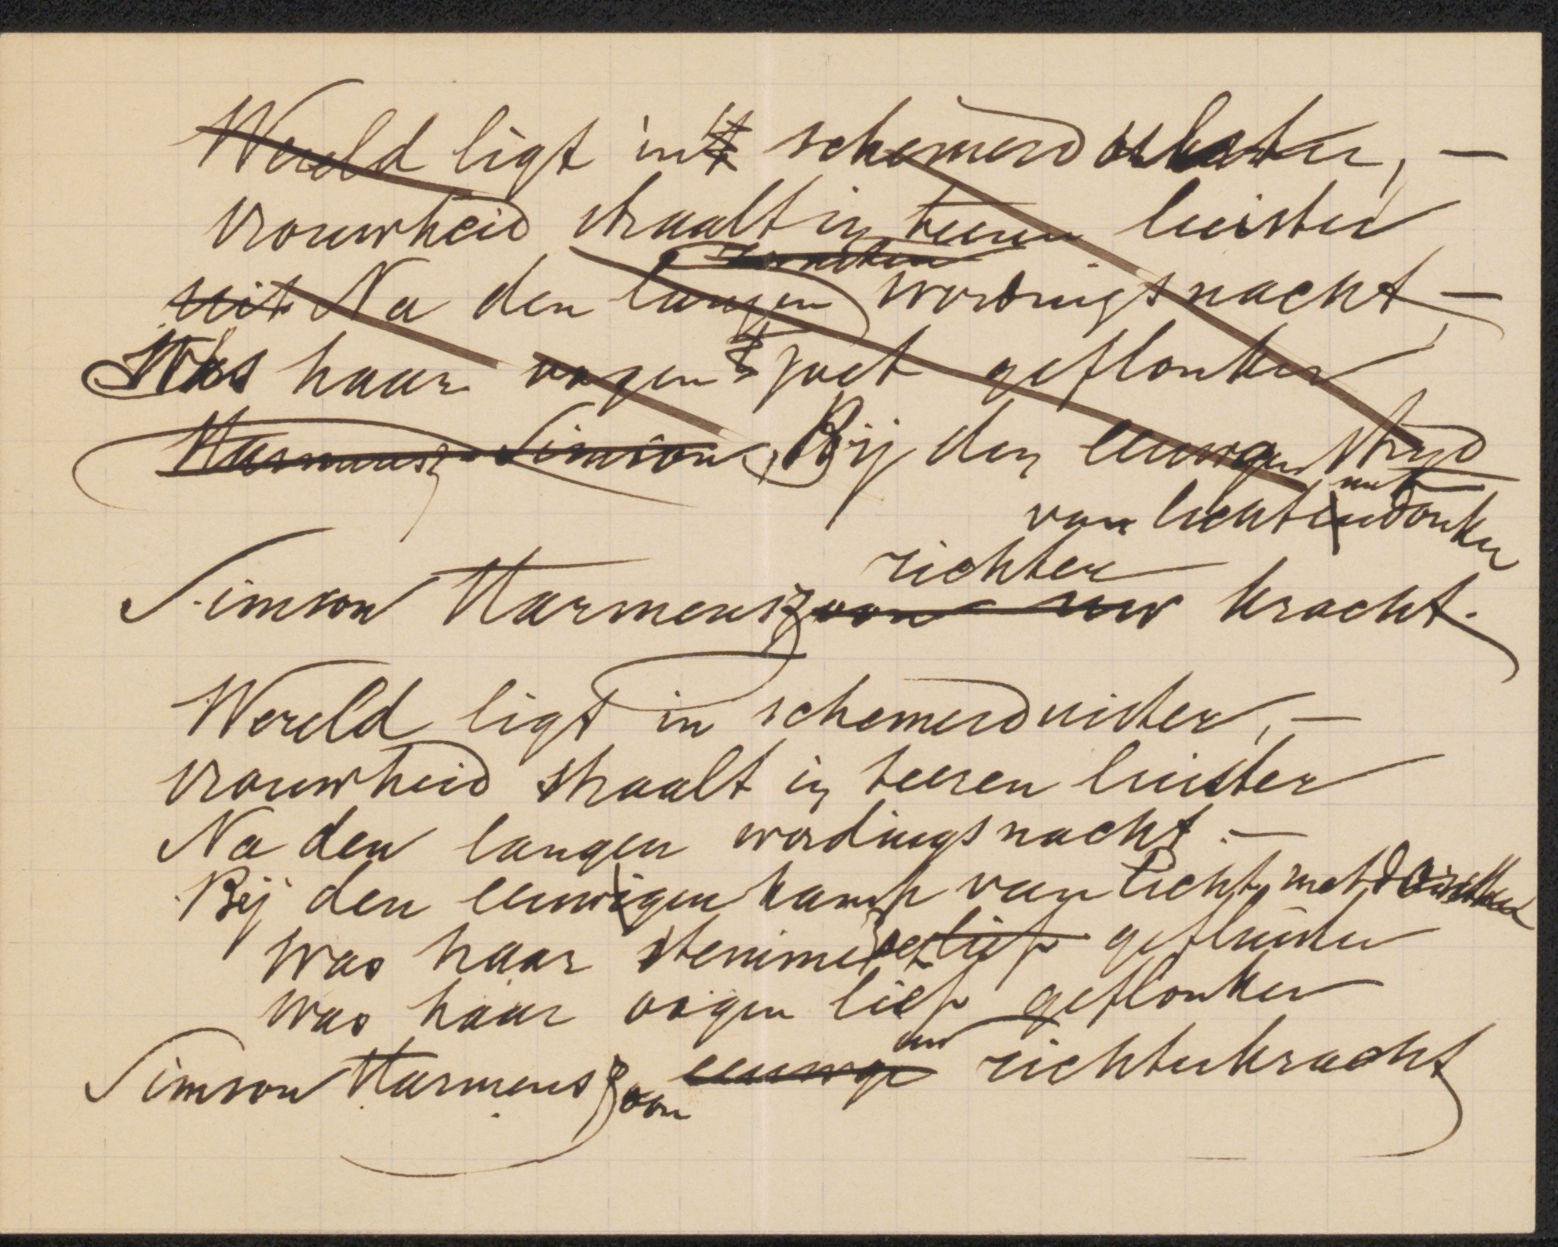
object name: poem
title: Gedicht uit collectie August Allebé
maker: august allebé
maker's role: draughtsman, print maker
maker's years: 1838-1927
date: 1848-1927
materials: ink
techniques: pen, writing